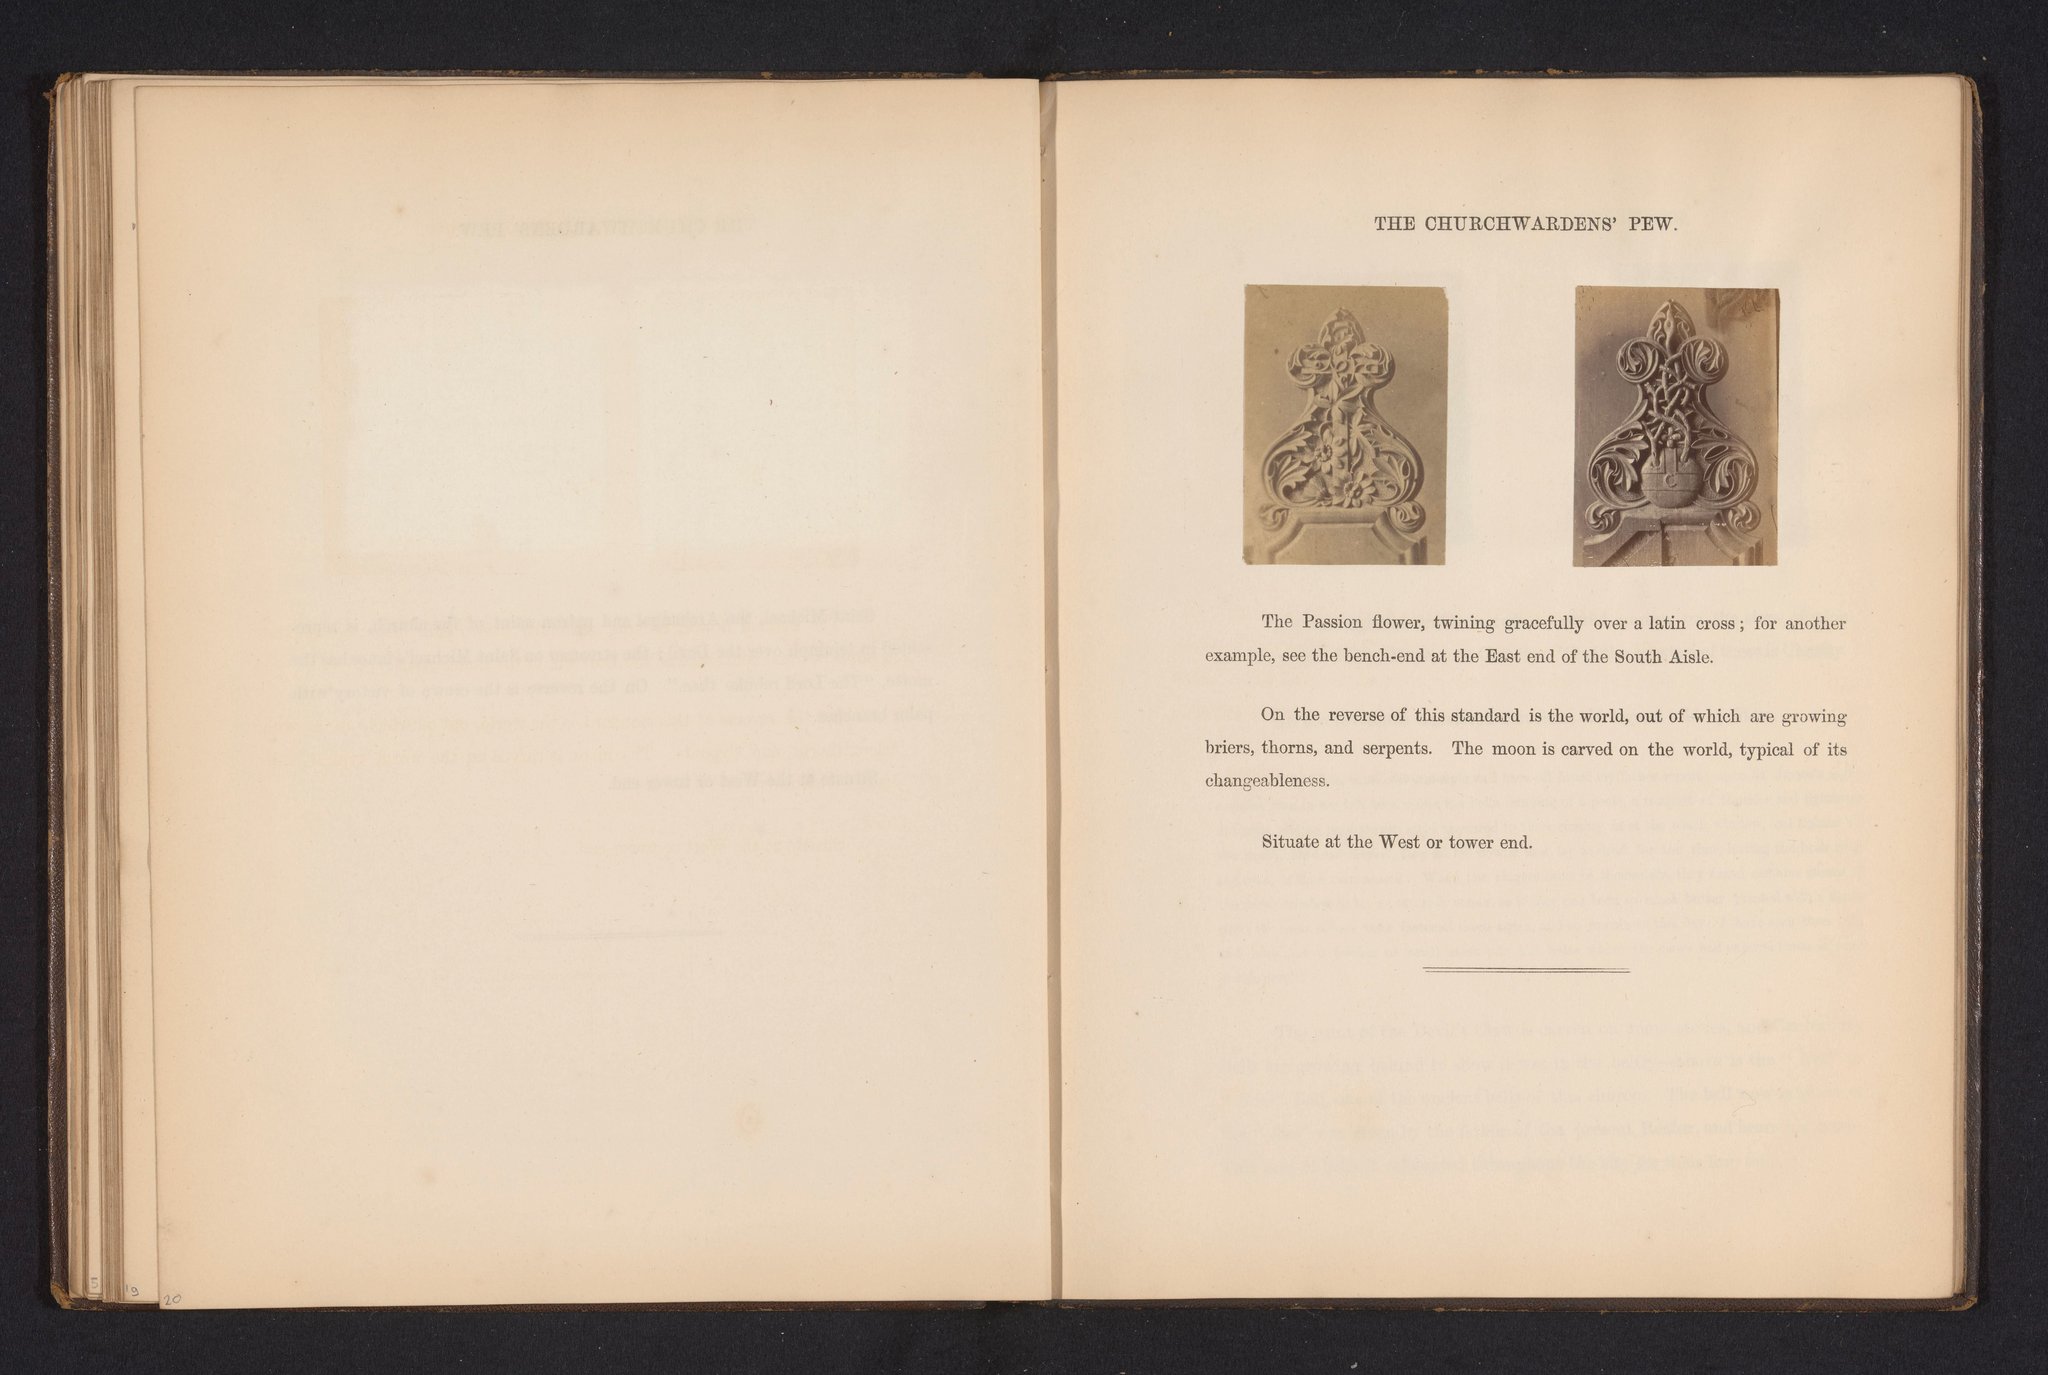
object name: page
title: Twee decoraties van kerkbanken voor kerkvoogden in de St Michael in Cornhill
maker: Anonymous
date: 1857-1867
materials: photographic support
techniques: albumen print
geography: st michael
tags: bench, the cross ~ symbols of christ, globe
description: Links: passiebloem rond een kruis, rechts: wereldbol waaruit rozebottels, doornen en slangen groeien.